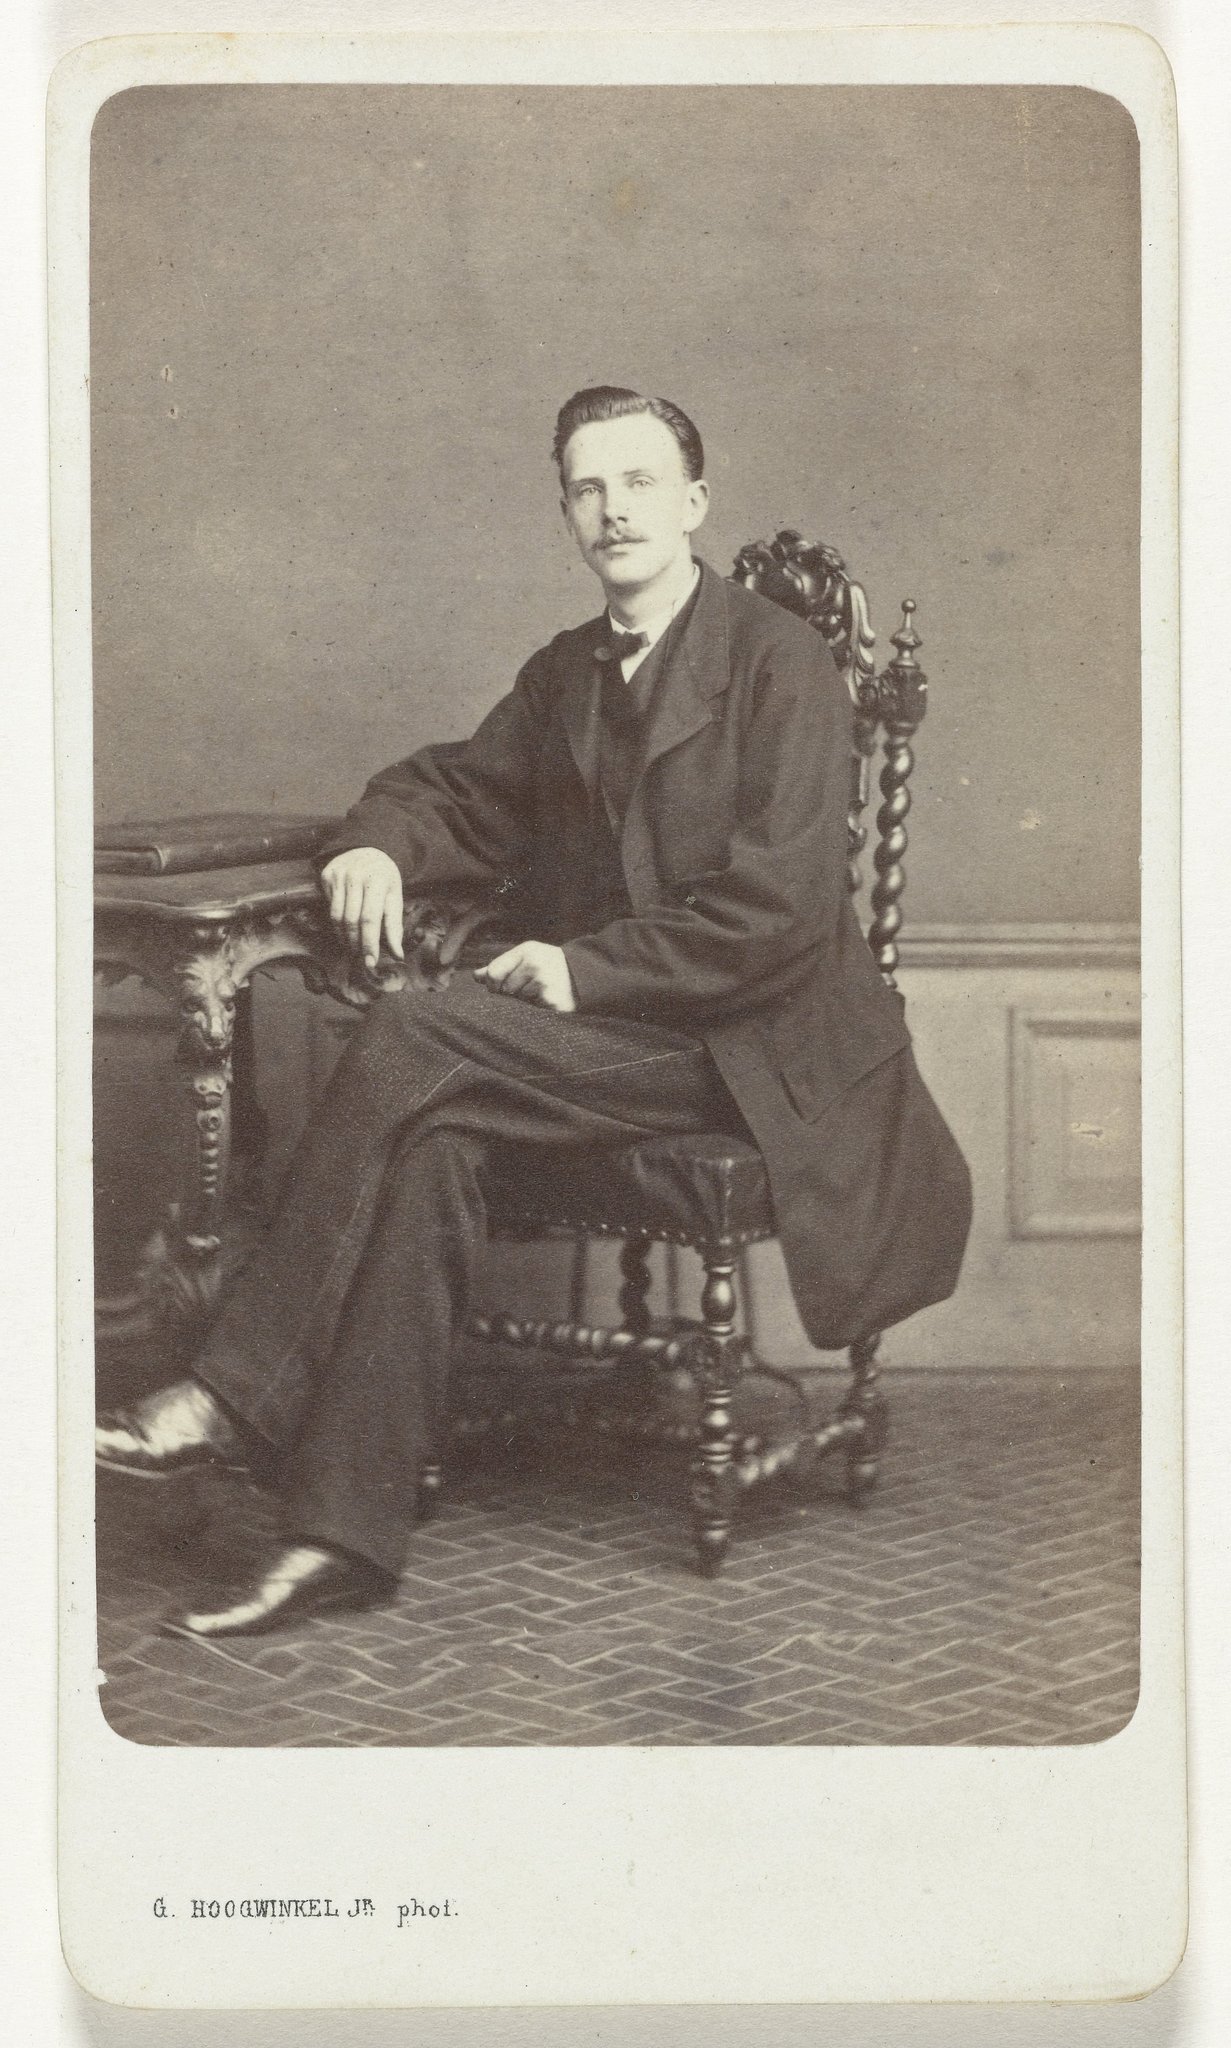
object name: carte de visite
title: Portret van een man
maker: gerrit hoogwinkel jr.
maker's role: fotograaf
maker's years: 1837-1890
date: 1865-1870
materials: cardboard, paper, photographic support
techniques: albumen print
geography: rotterdam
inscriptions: signature and address: ‘G. Hoogwinkel jr/Photographe/Rotterdam/56, Hoogstraat’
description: Man met snor, zittend aan een tafel waarop een groot boek ligt.